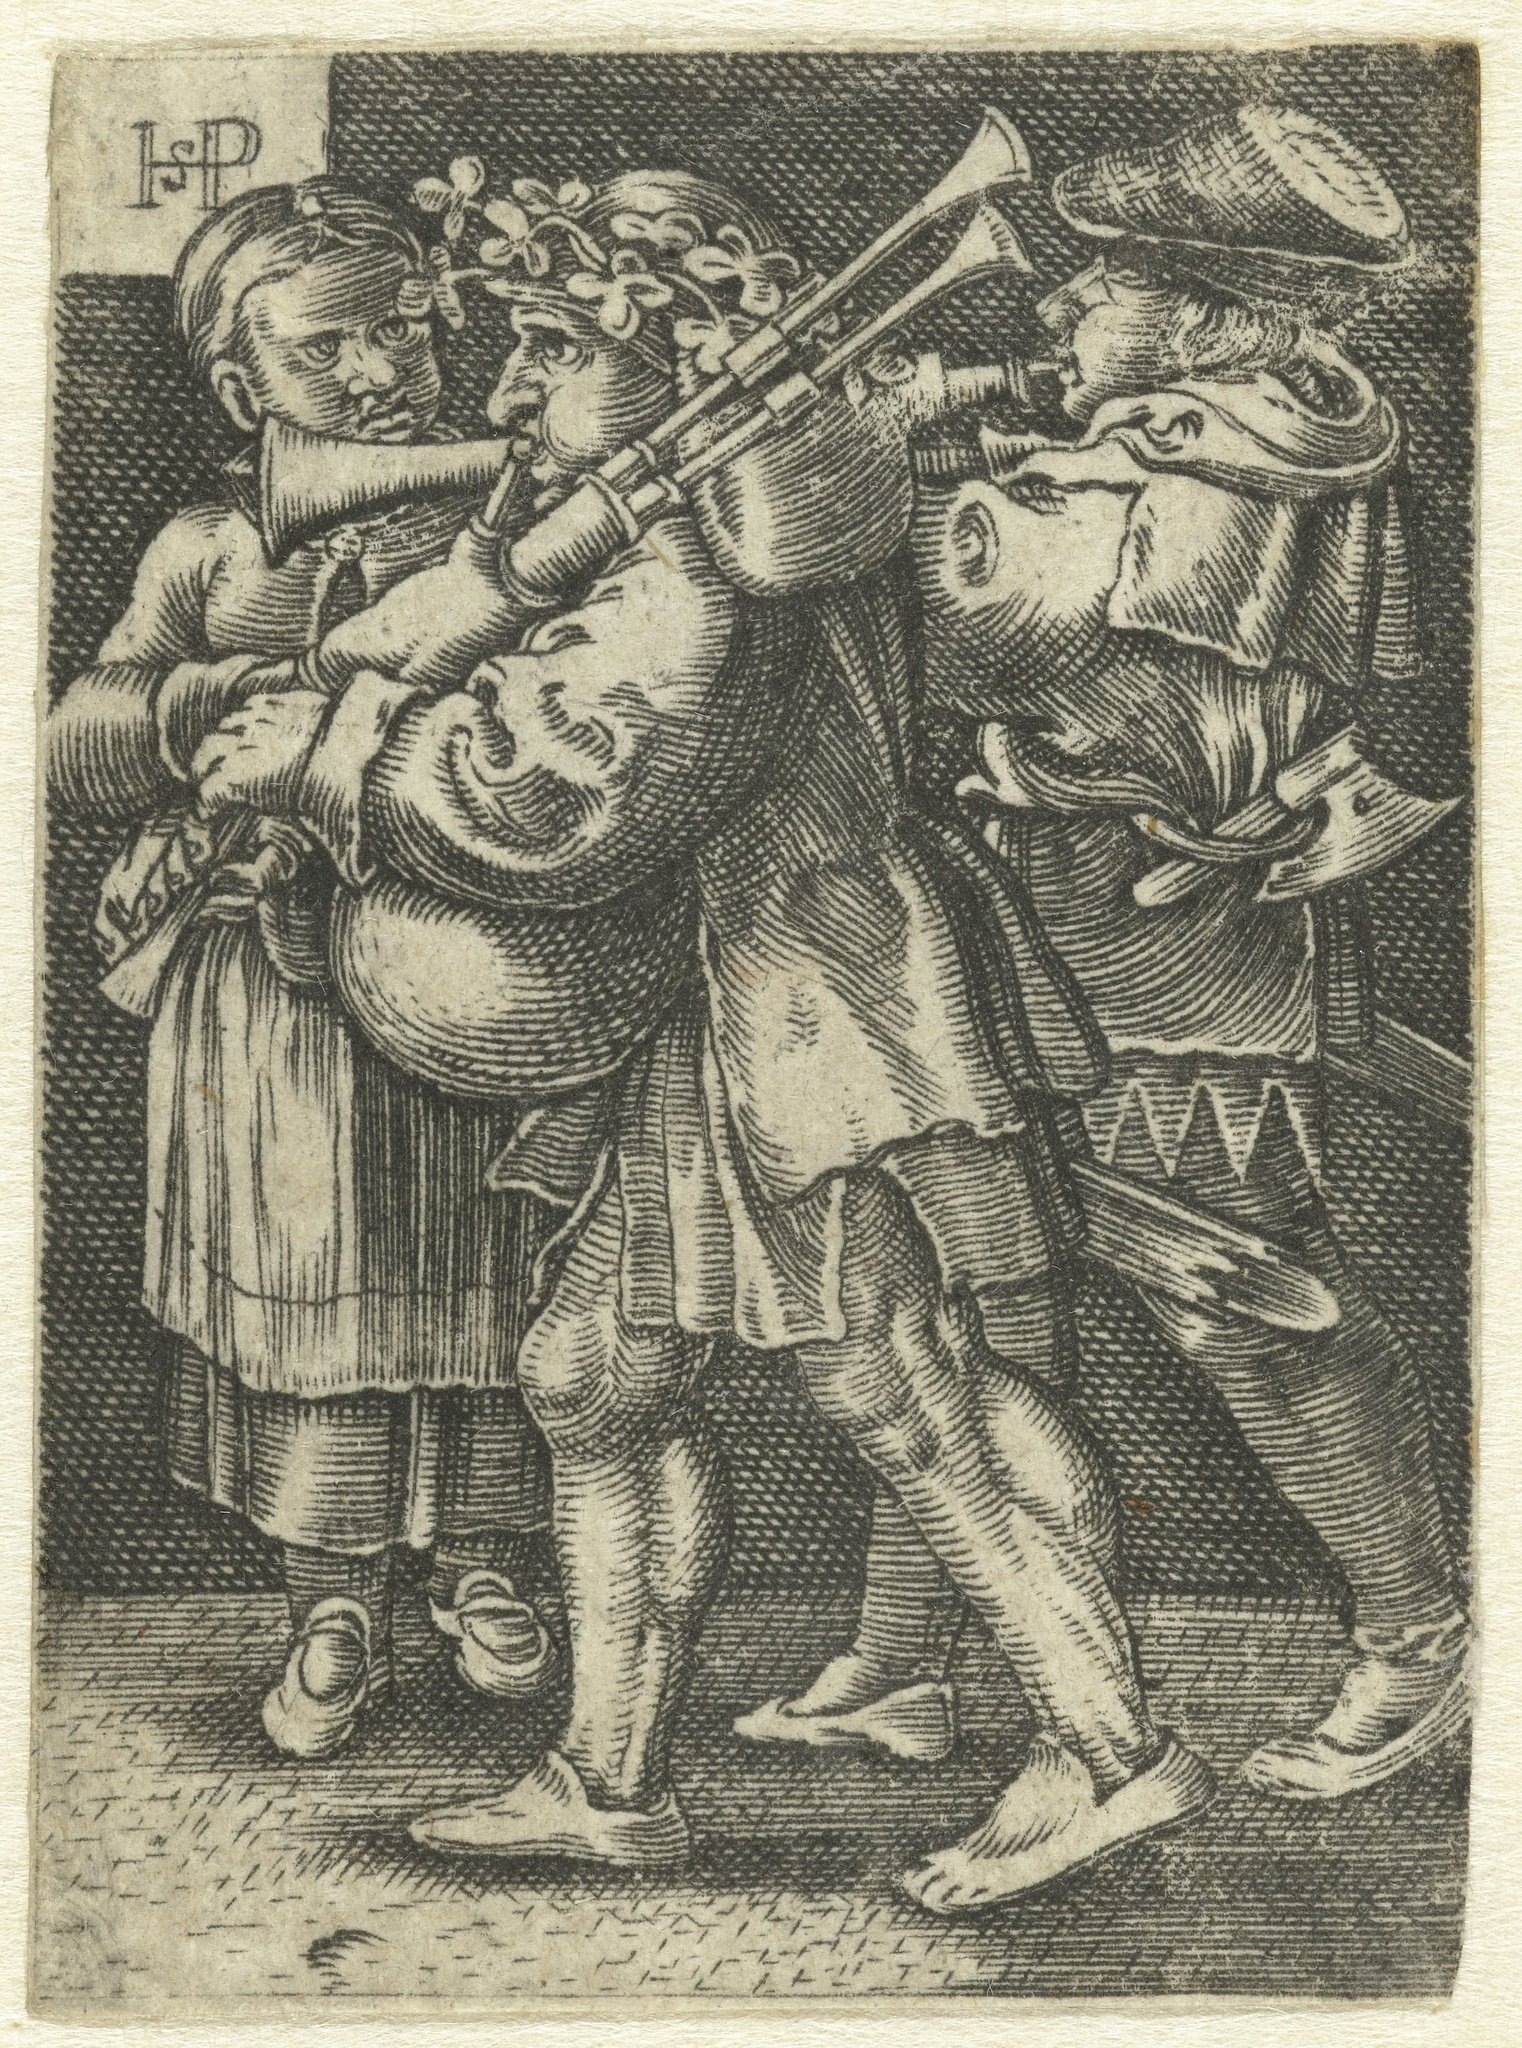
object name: print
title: Twee muzikanten en een meisje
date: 1510-1599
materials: paper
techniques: engraving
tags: bagpipe, musette, more than one musician with instrument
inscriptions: collector's mark: Lugt 240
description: Kopie in spiegelbeeld naar een prent van Hans Sebald Beham.